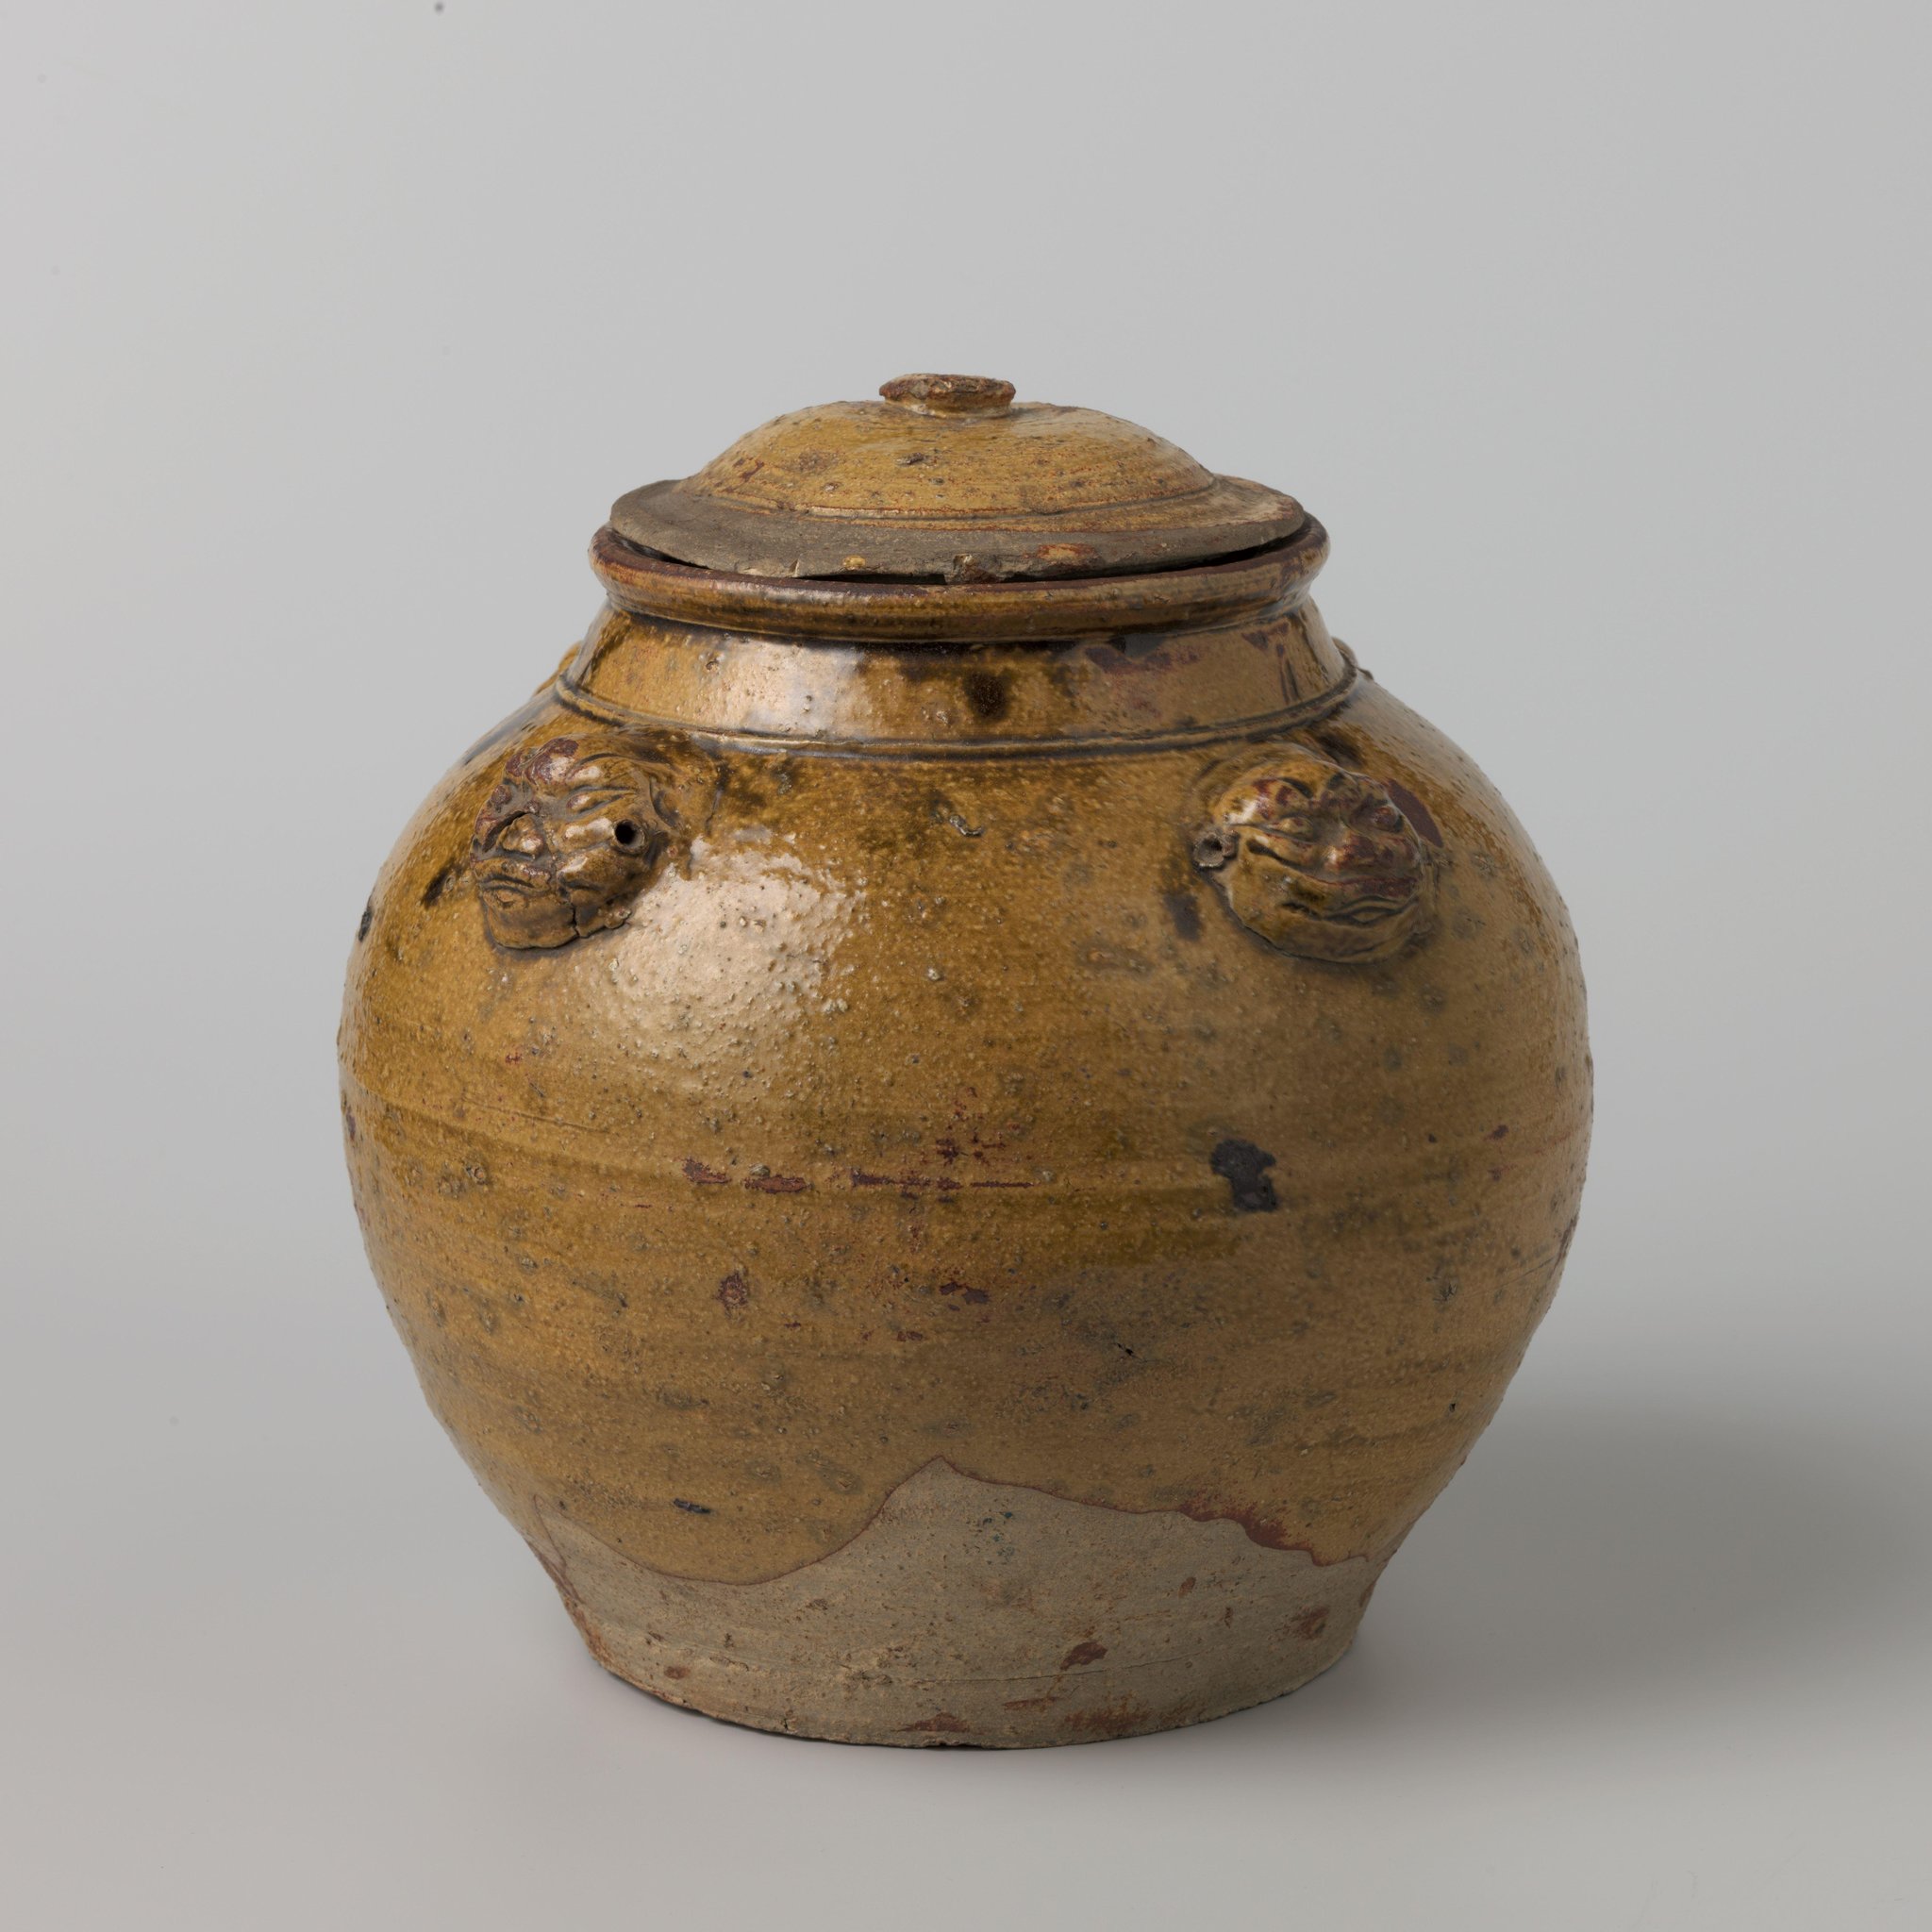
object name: lid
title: Ovoid covered jar with four moulded monster heads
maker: Anonymous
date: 618-907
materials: earthenware, glaze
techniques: firing, forming, turning, vitrification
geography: china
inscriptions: label: ‘Br. Jeltes no. 22’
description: Deksel van eivormige dekselpot van aardewerk met een korte hals en platte rand, gedeeltelijk bedekt met een geel glazuur. De deksel heeft een platte knop. Deksel is gebroken geweest.